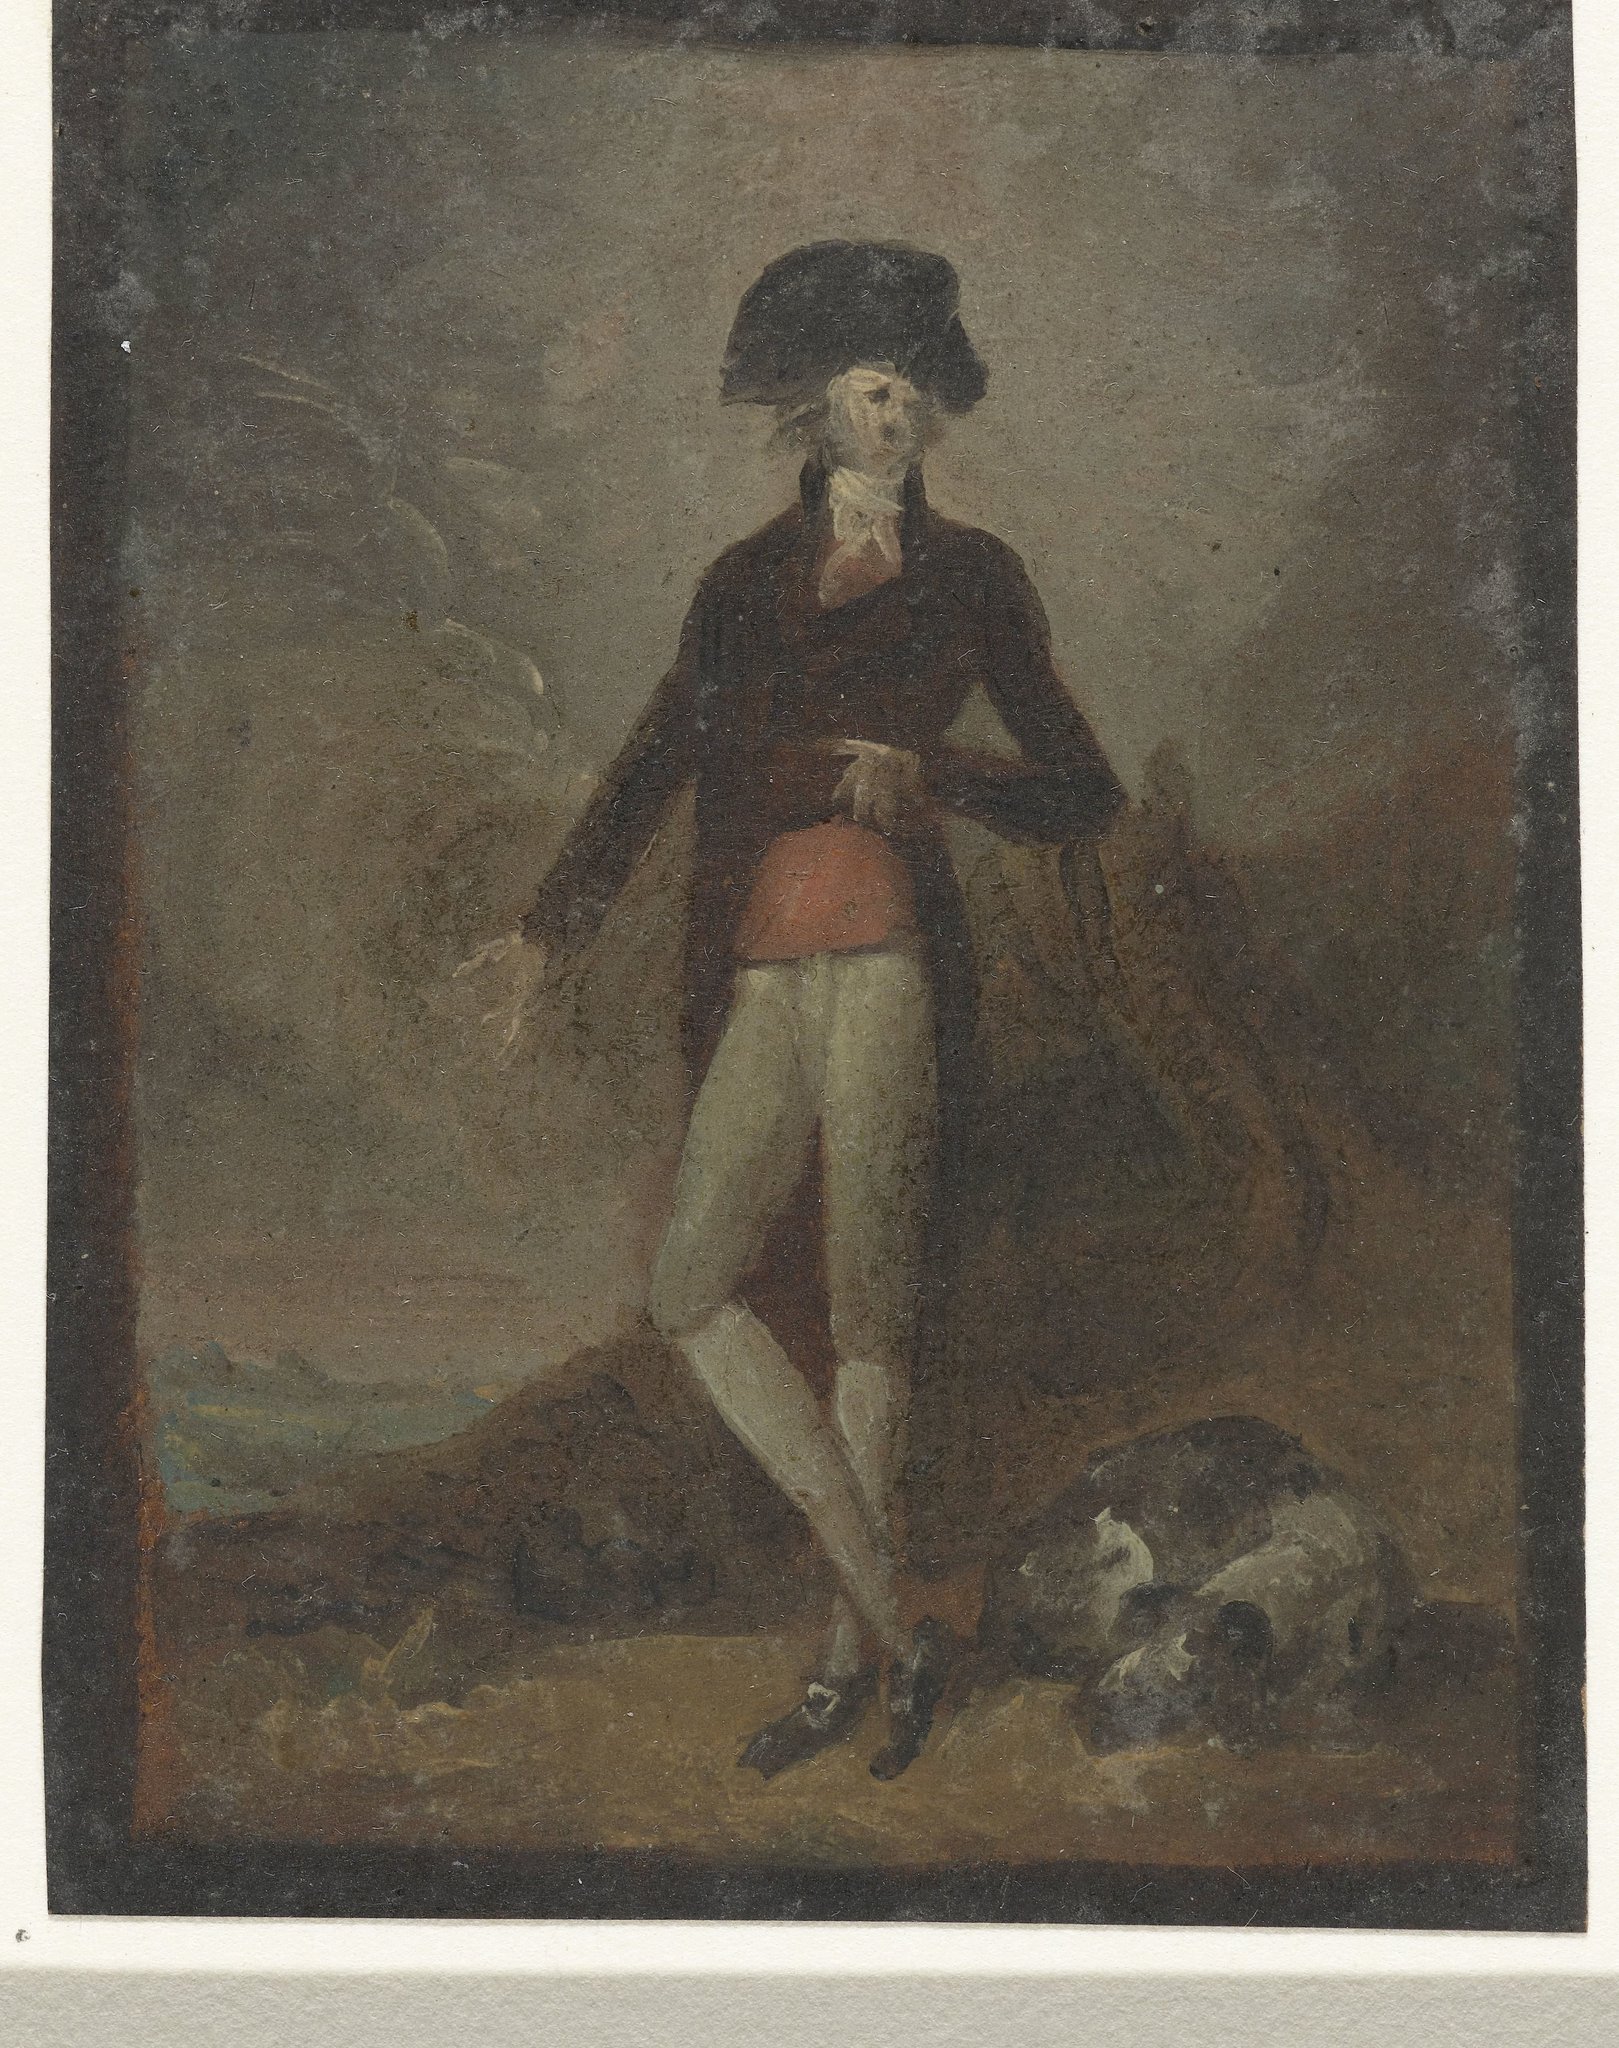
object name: drawing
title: Staande man met hond aan zijn voeten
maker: Anonymous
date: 1700-1800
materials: oil, paper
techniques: brush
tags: dog